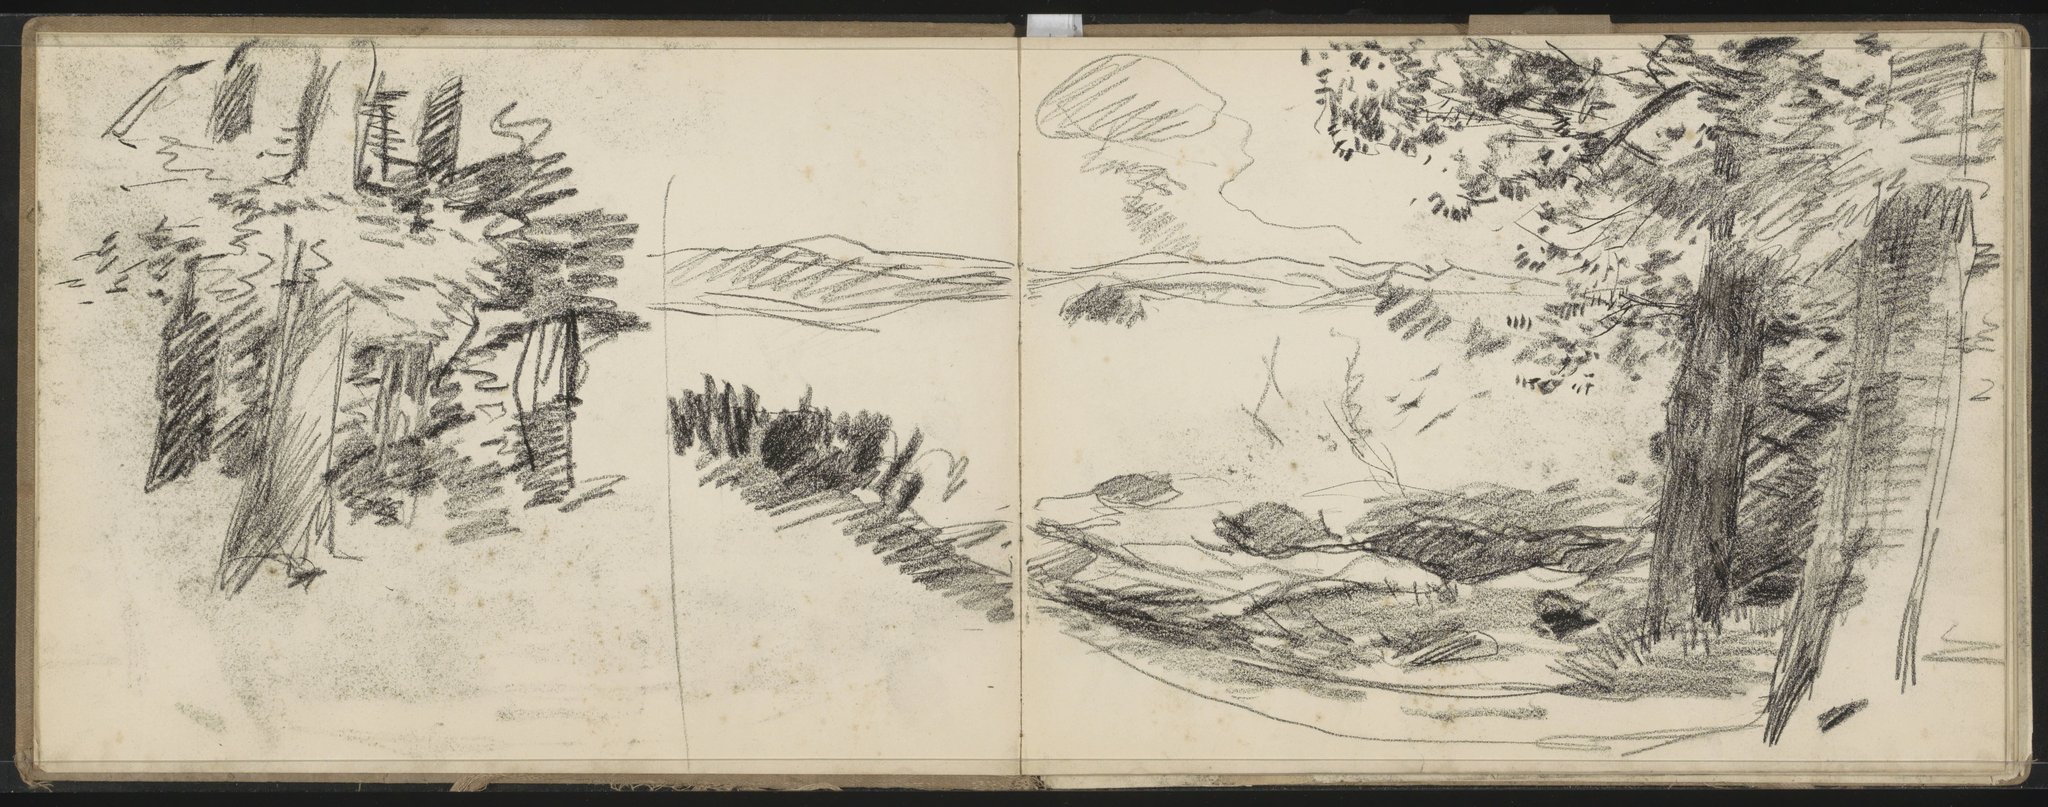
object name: sketchbook leaf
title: Heuvellandschap met bomen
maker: willem bastiaan tholen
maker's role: draughtsman, painter, print maker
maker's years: 1860-1931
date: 1870-1931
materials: chalk, paper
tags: low hill country, trees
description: Blad 1 verso en 2 recto uit een schetsboek met 22 bladen.